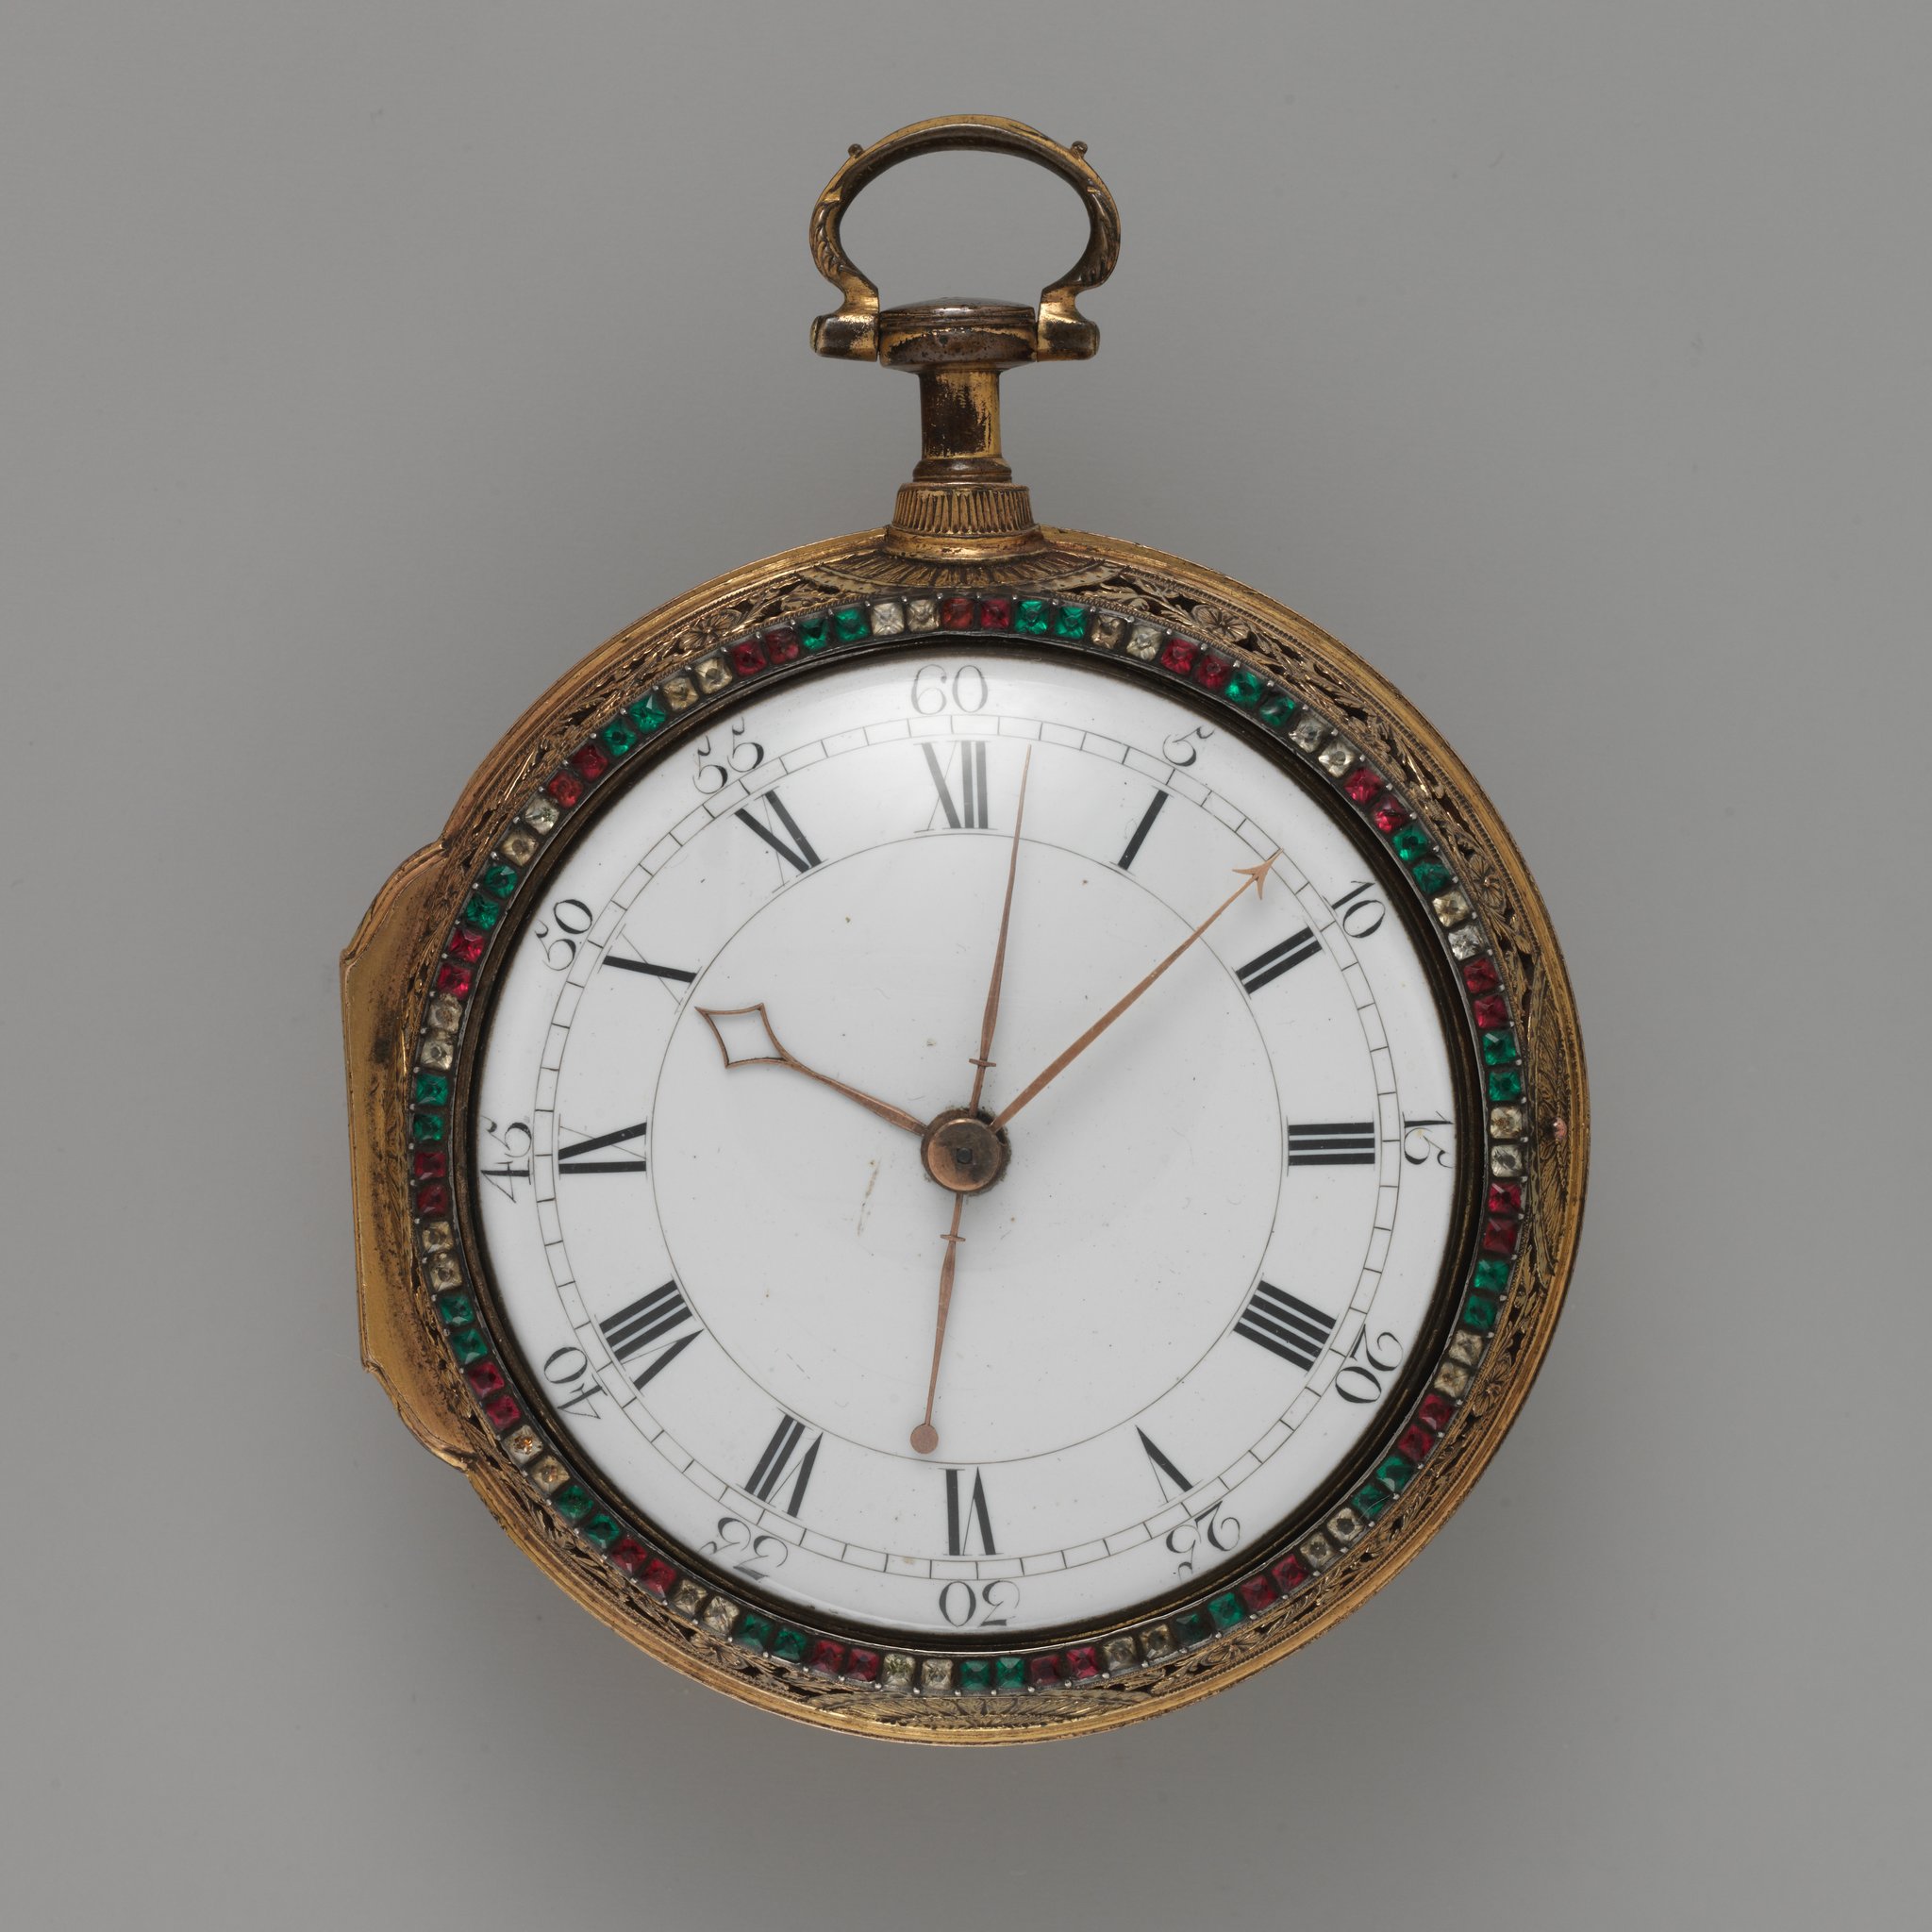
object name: watch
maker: william travers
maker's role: maker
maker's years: 1781-1811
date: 1801-1833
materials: enamel, gilt bronze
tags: men,women,flutes,dogs,sheep,flowers,trees,shepherds